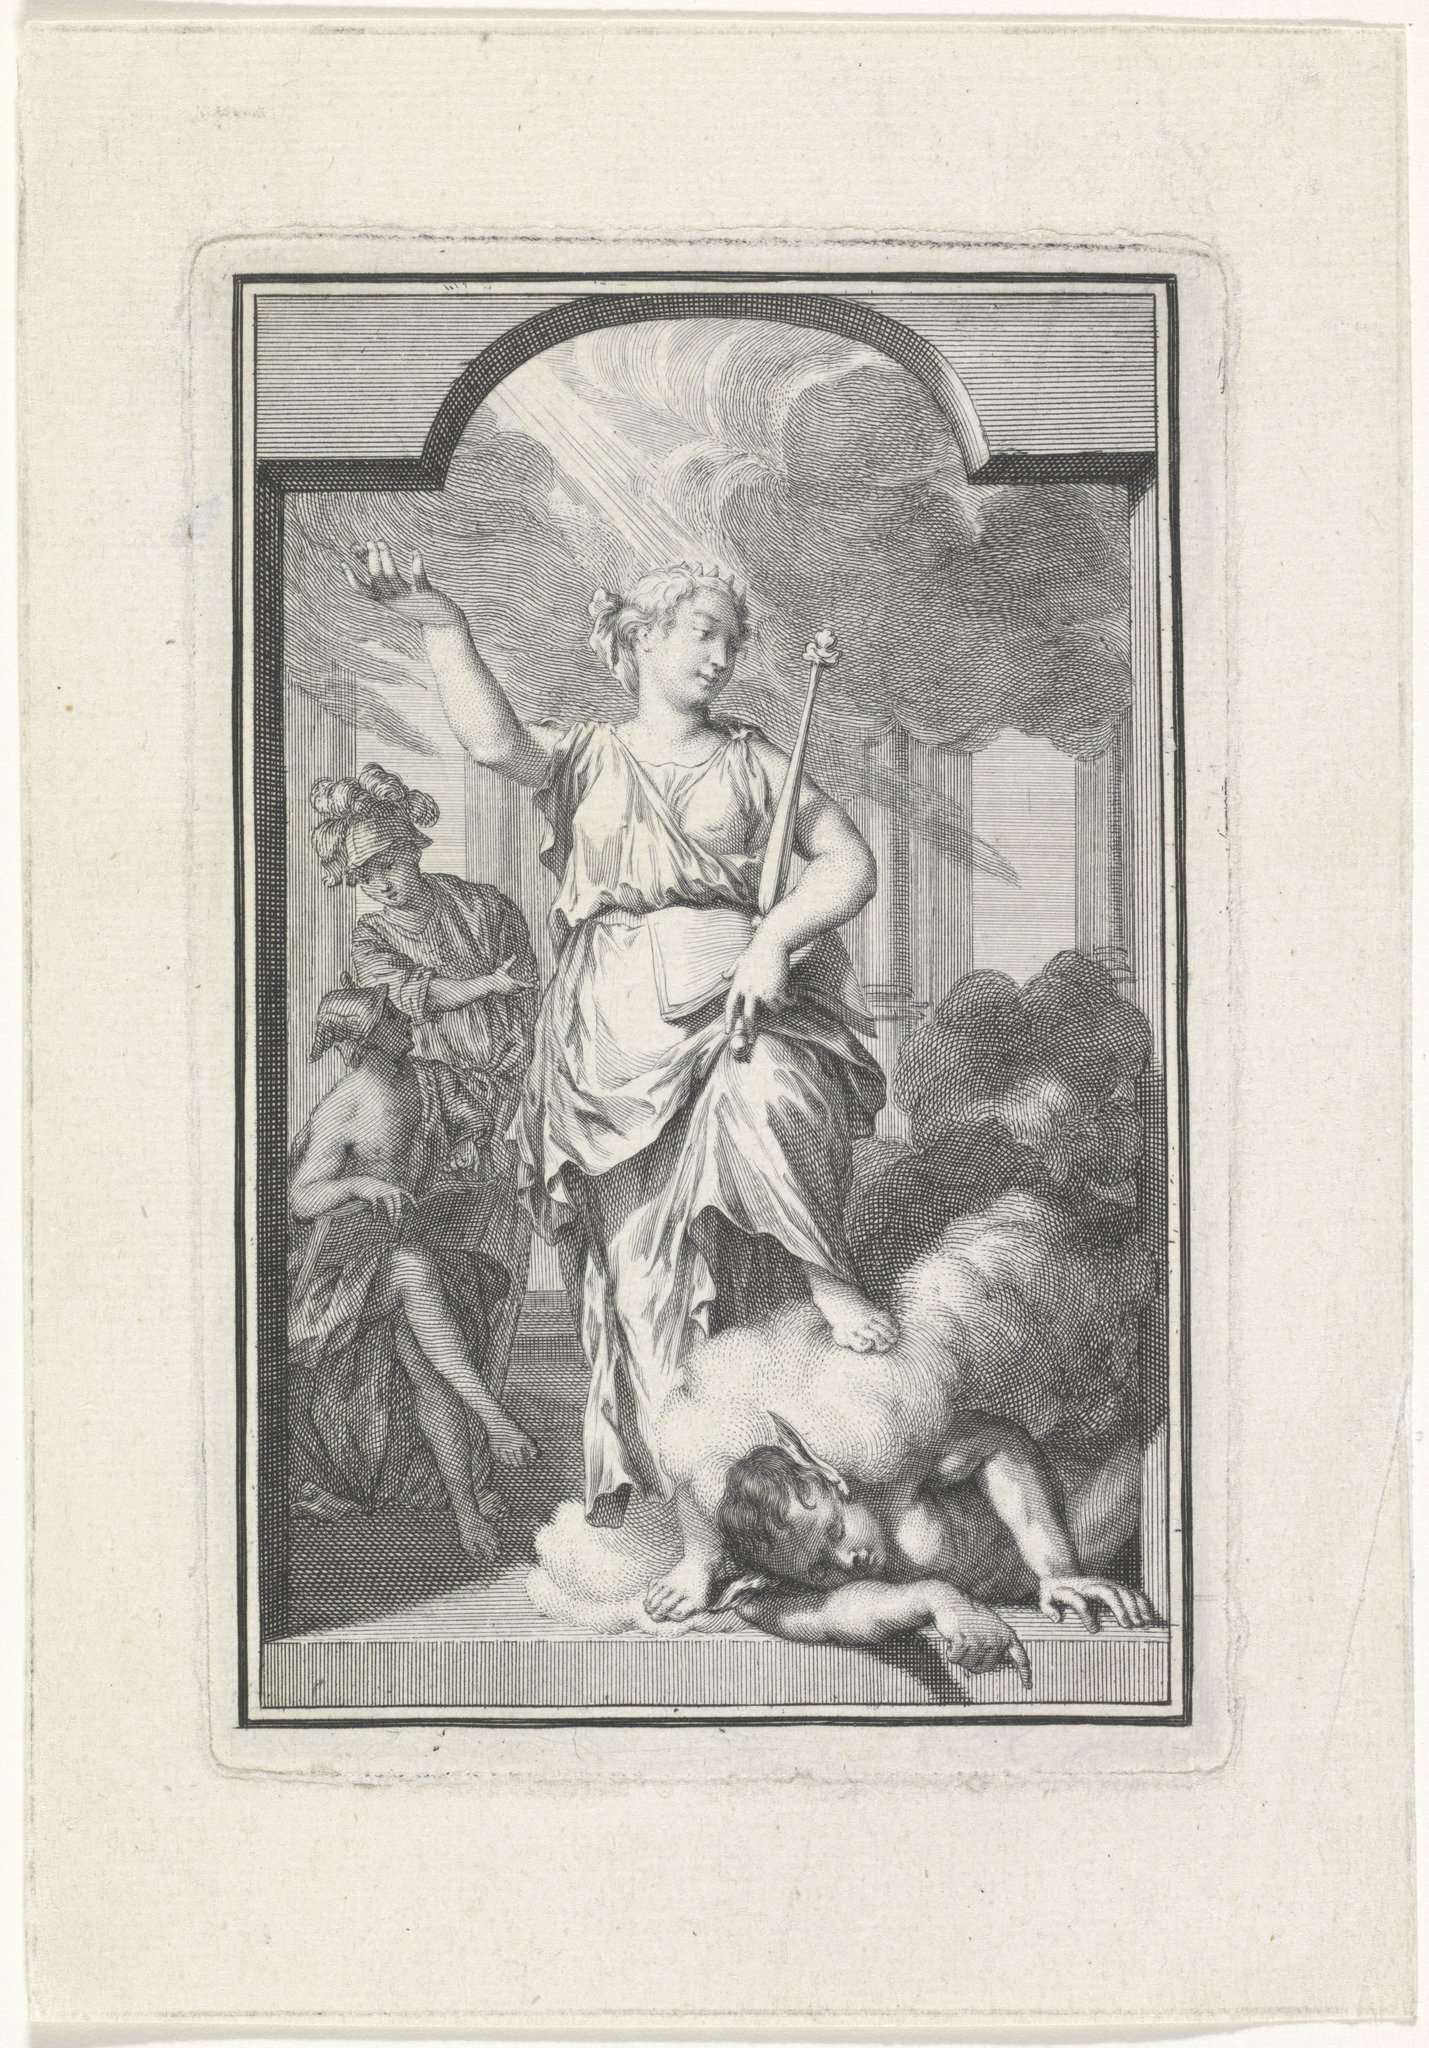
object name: print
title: Allegorie met de overwinning op de Domheid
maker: Anonymous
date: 1700-1800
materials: paper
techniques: engraving, etching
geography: netherlands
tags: truth; 'verità' (ripa) (+ personification), (story of) minerva (pallas, athena), (story of) mercury (hermes), stupidity, poverty of intellect; 'stupidità overo stolidità' (ripa)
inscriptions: collector's mark: Lugt 240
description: De Waarheid met scepter en boek in de hand staat met een voet op de Domheid, een man met ezelsoren, ten teken van haar overwinning op hem. Links Mercurius en Minerva.